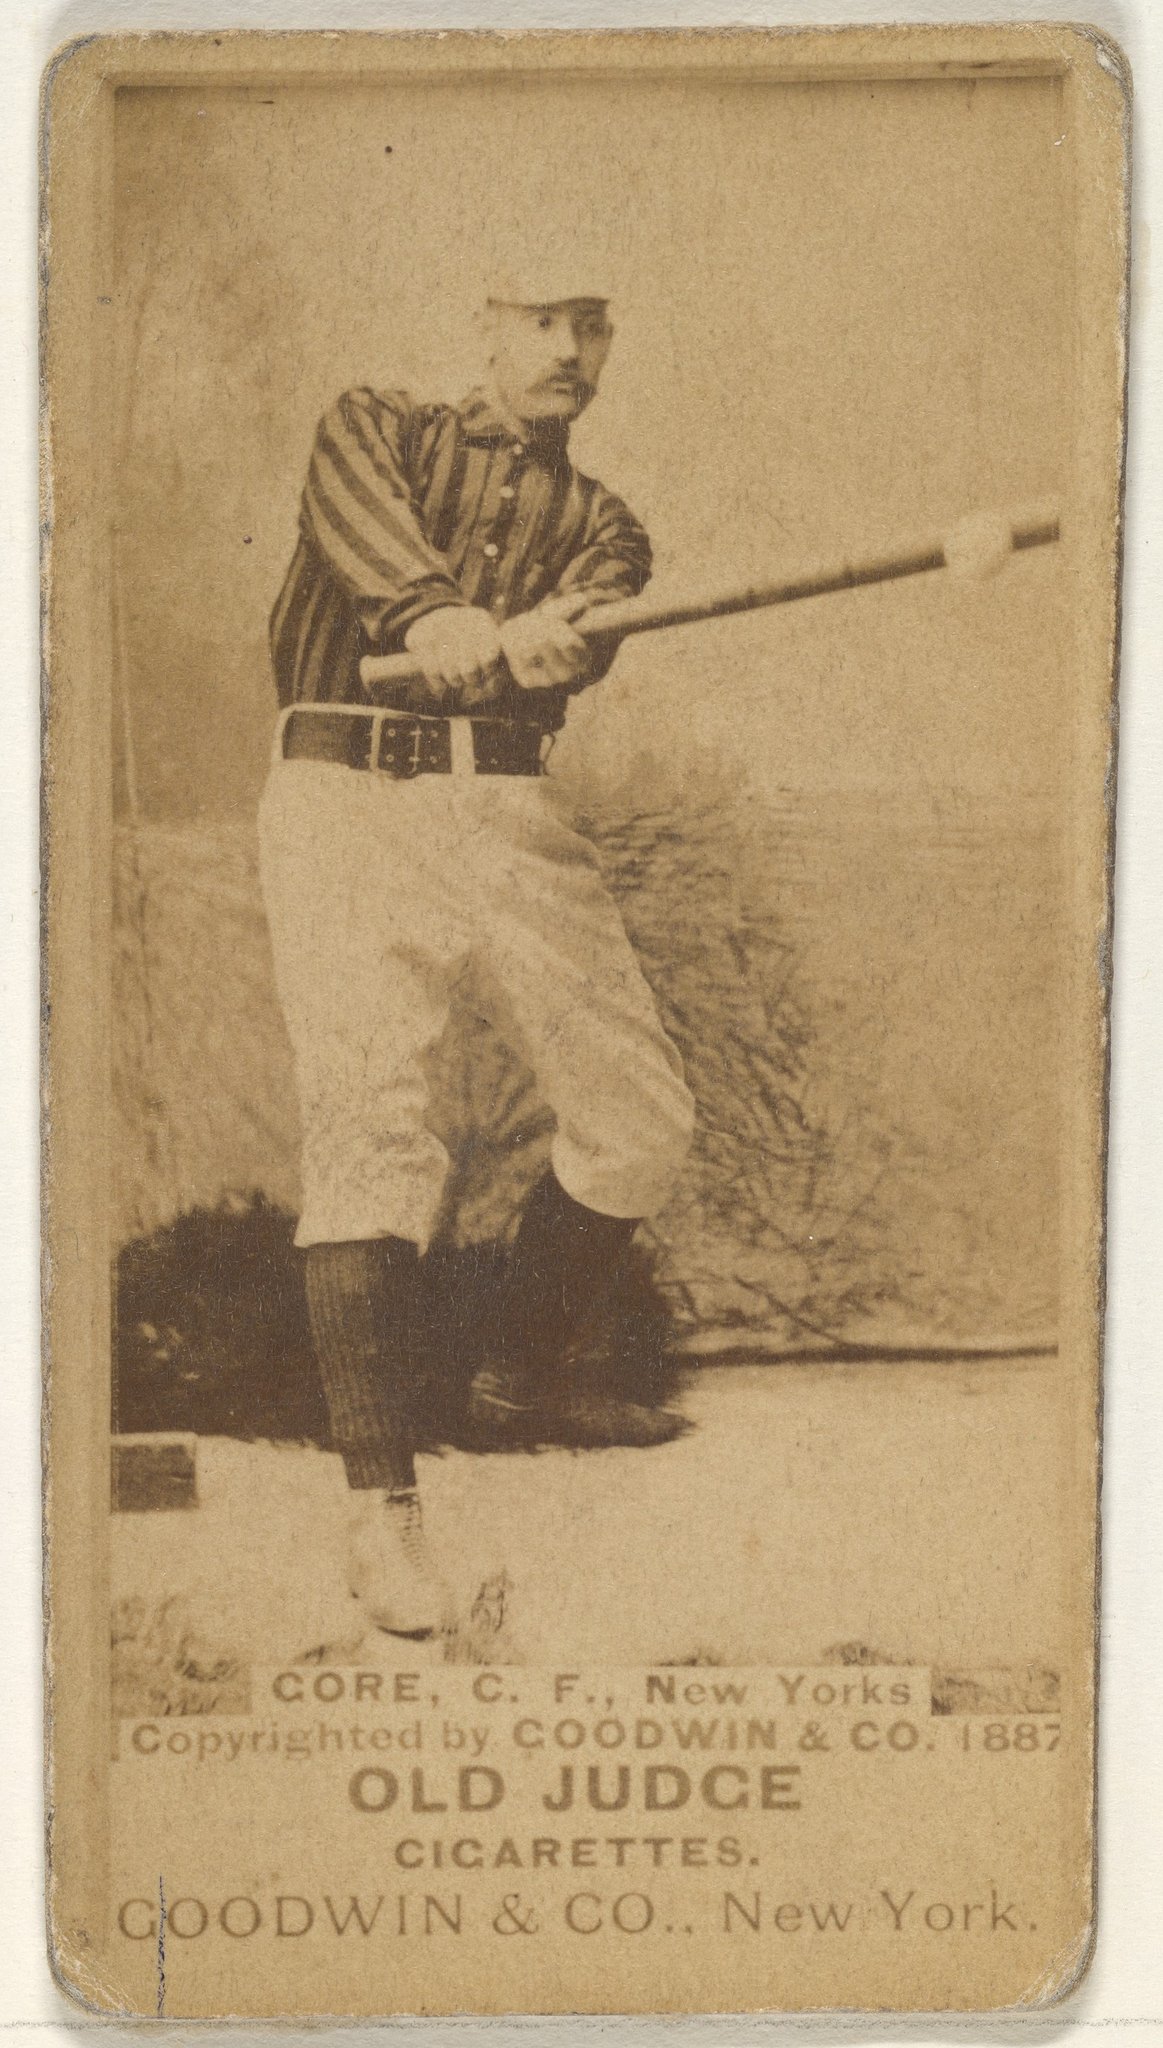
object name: baseball card, photograph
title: George F. "Piano Legs" Gore, Center Field, New York, from the Old Judge series (N172) for Old Judge Cigarettes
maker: goodwin & company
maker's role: publisher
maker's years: 1850-1950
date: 1887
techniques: albumen silver print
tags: men,portraits,baseball,athletes